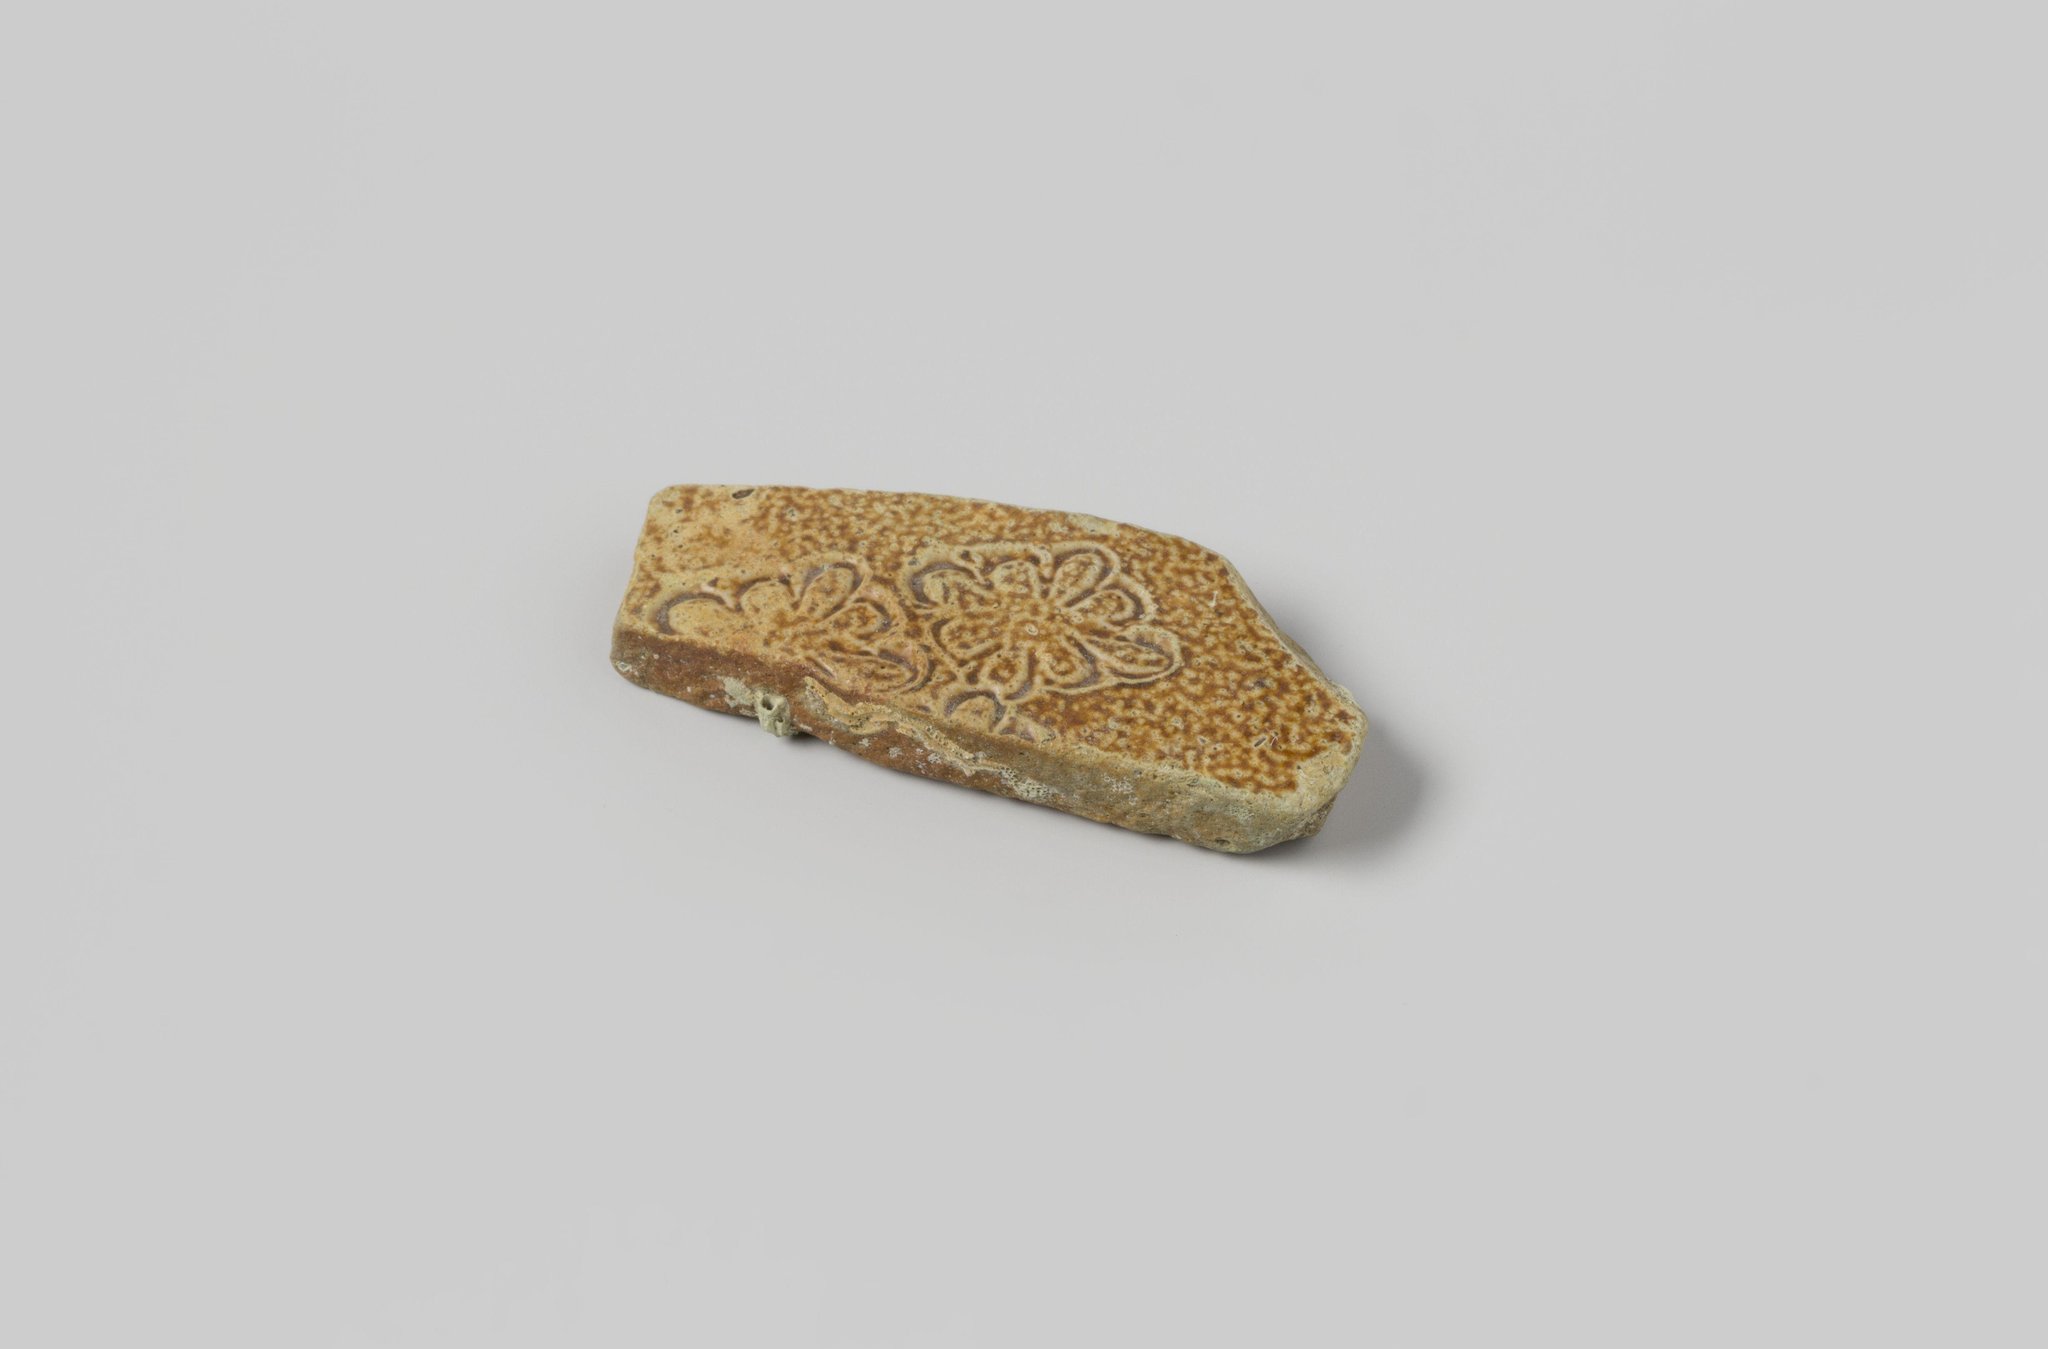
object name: sherd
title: Scherf van een kan uit het wrak van de Oost-Indiëvaarder Hollandia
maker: Anonymous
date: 1700-1743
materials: stoneware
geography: cologne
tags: verenigde oostindische compagnie, hollandia (schip), annet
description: Stoneware, Rhenish, Frechen-ware, jug; fragm of body with rosette-shaped stamps.